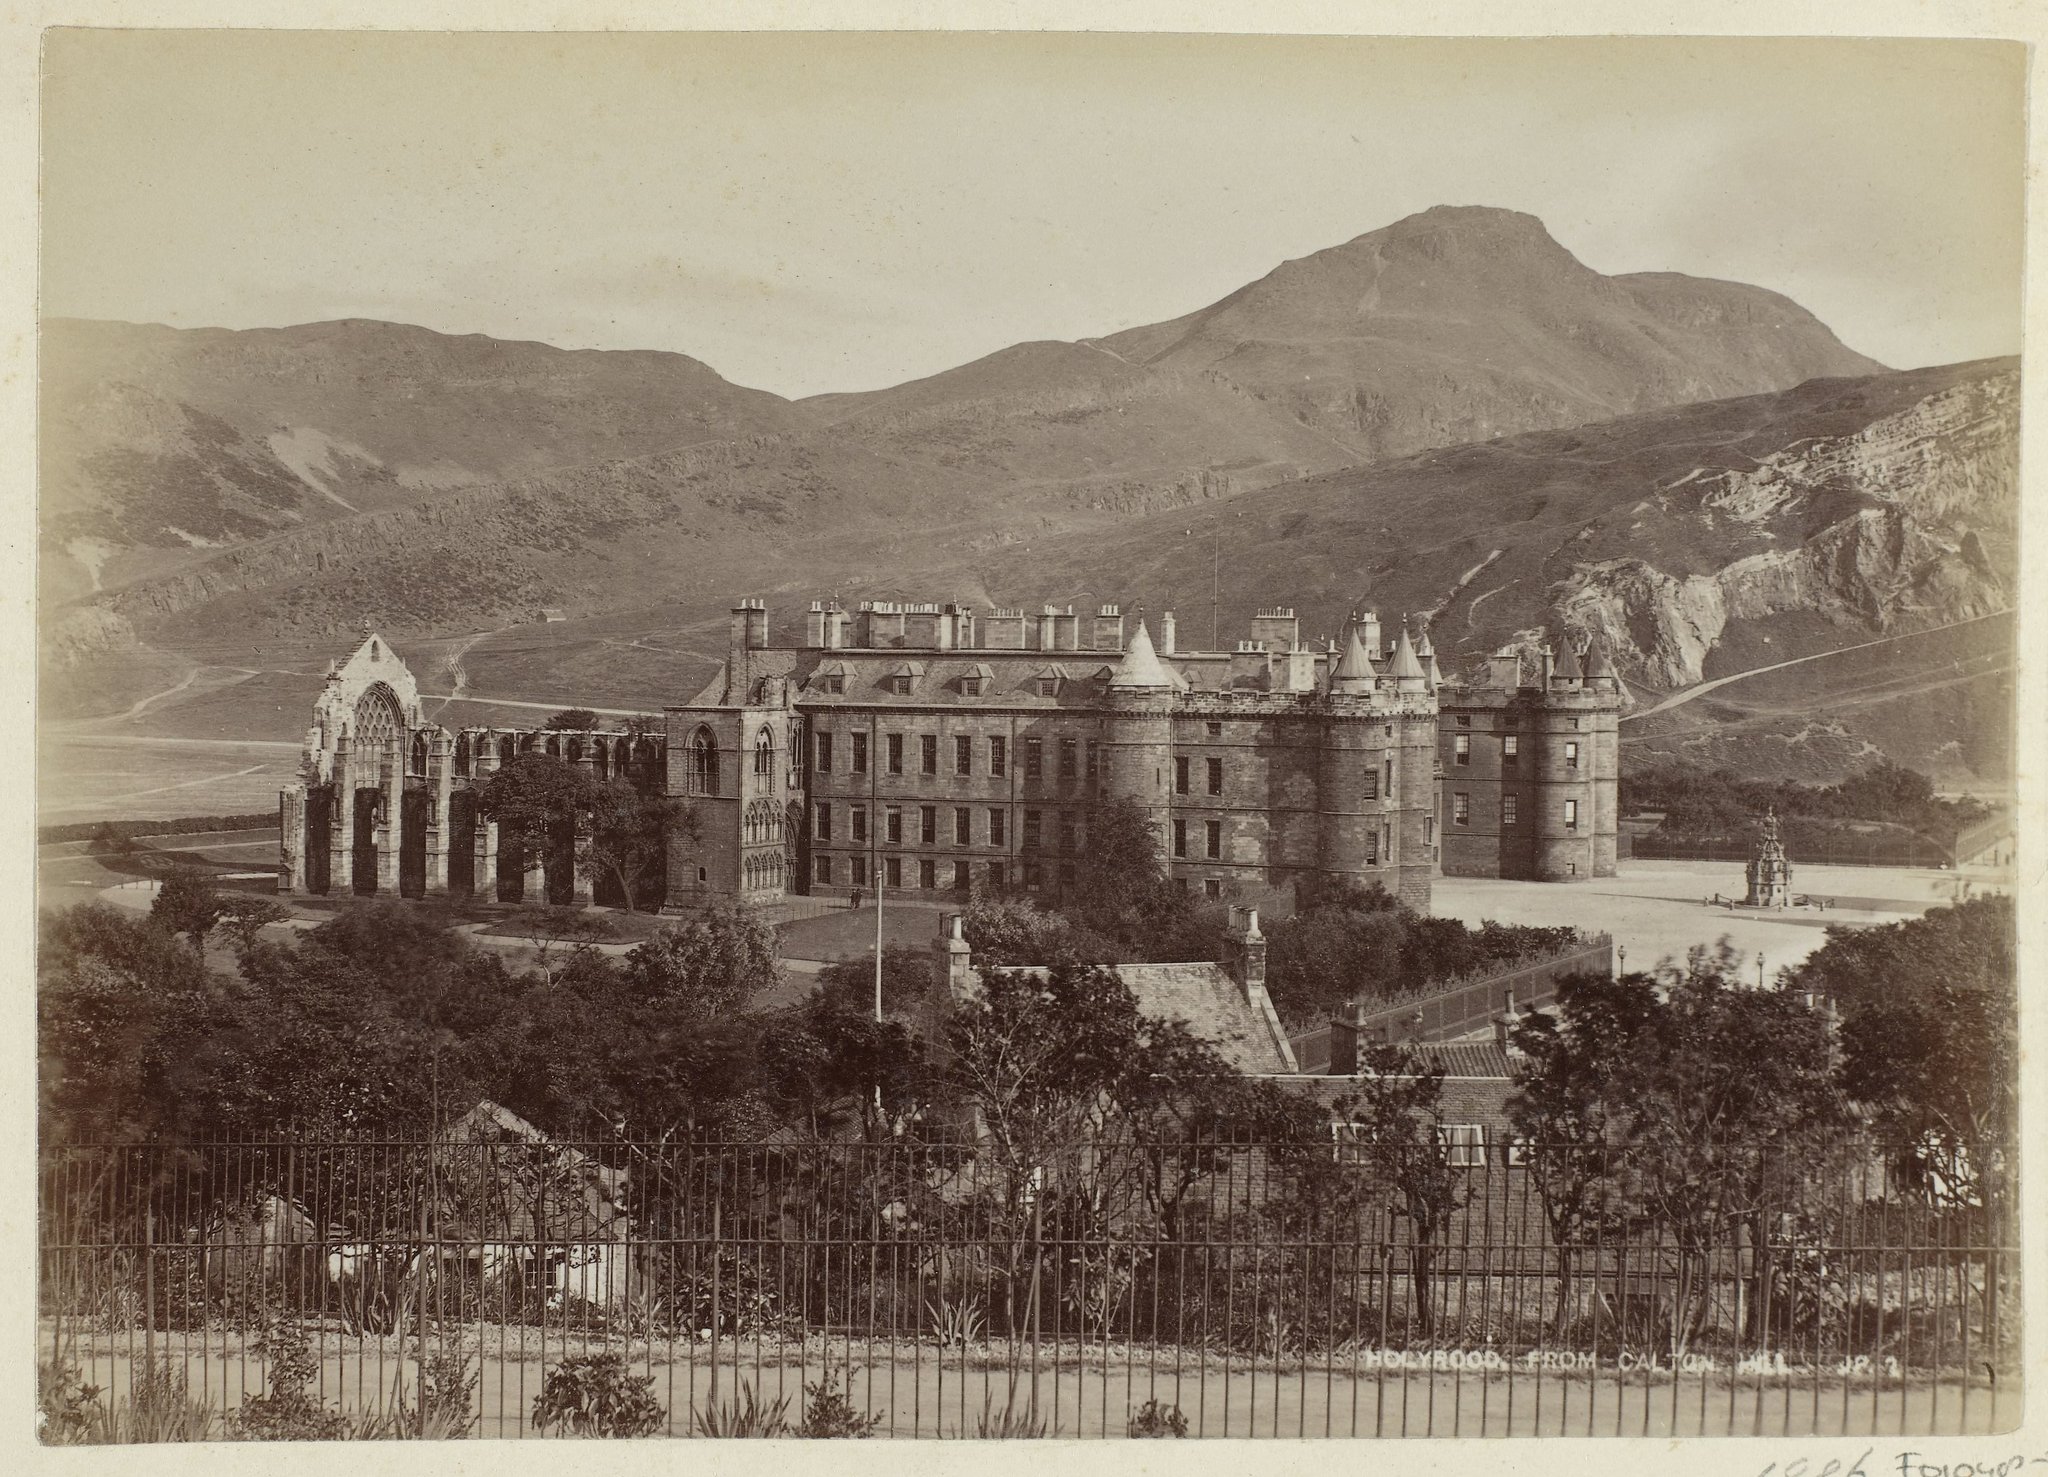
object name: photograph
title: Holyrood, from Calton Hill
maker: john patrick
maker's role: fotograaf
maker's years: 1831-1923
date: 1870-1886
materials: paper, photographic support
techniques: albumen print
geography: edinburgh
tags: palace, ruin of a dwelling, house, castle, etc.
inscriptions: negative number: ‘2’, date: ‘1886’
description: Onderdeel van Reisalbum van H. Dunlop met foto's van bezienswaardigheden in Perzië, Schotland, Duitsland, Rusland, China en Canada.